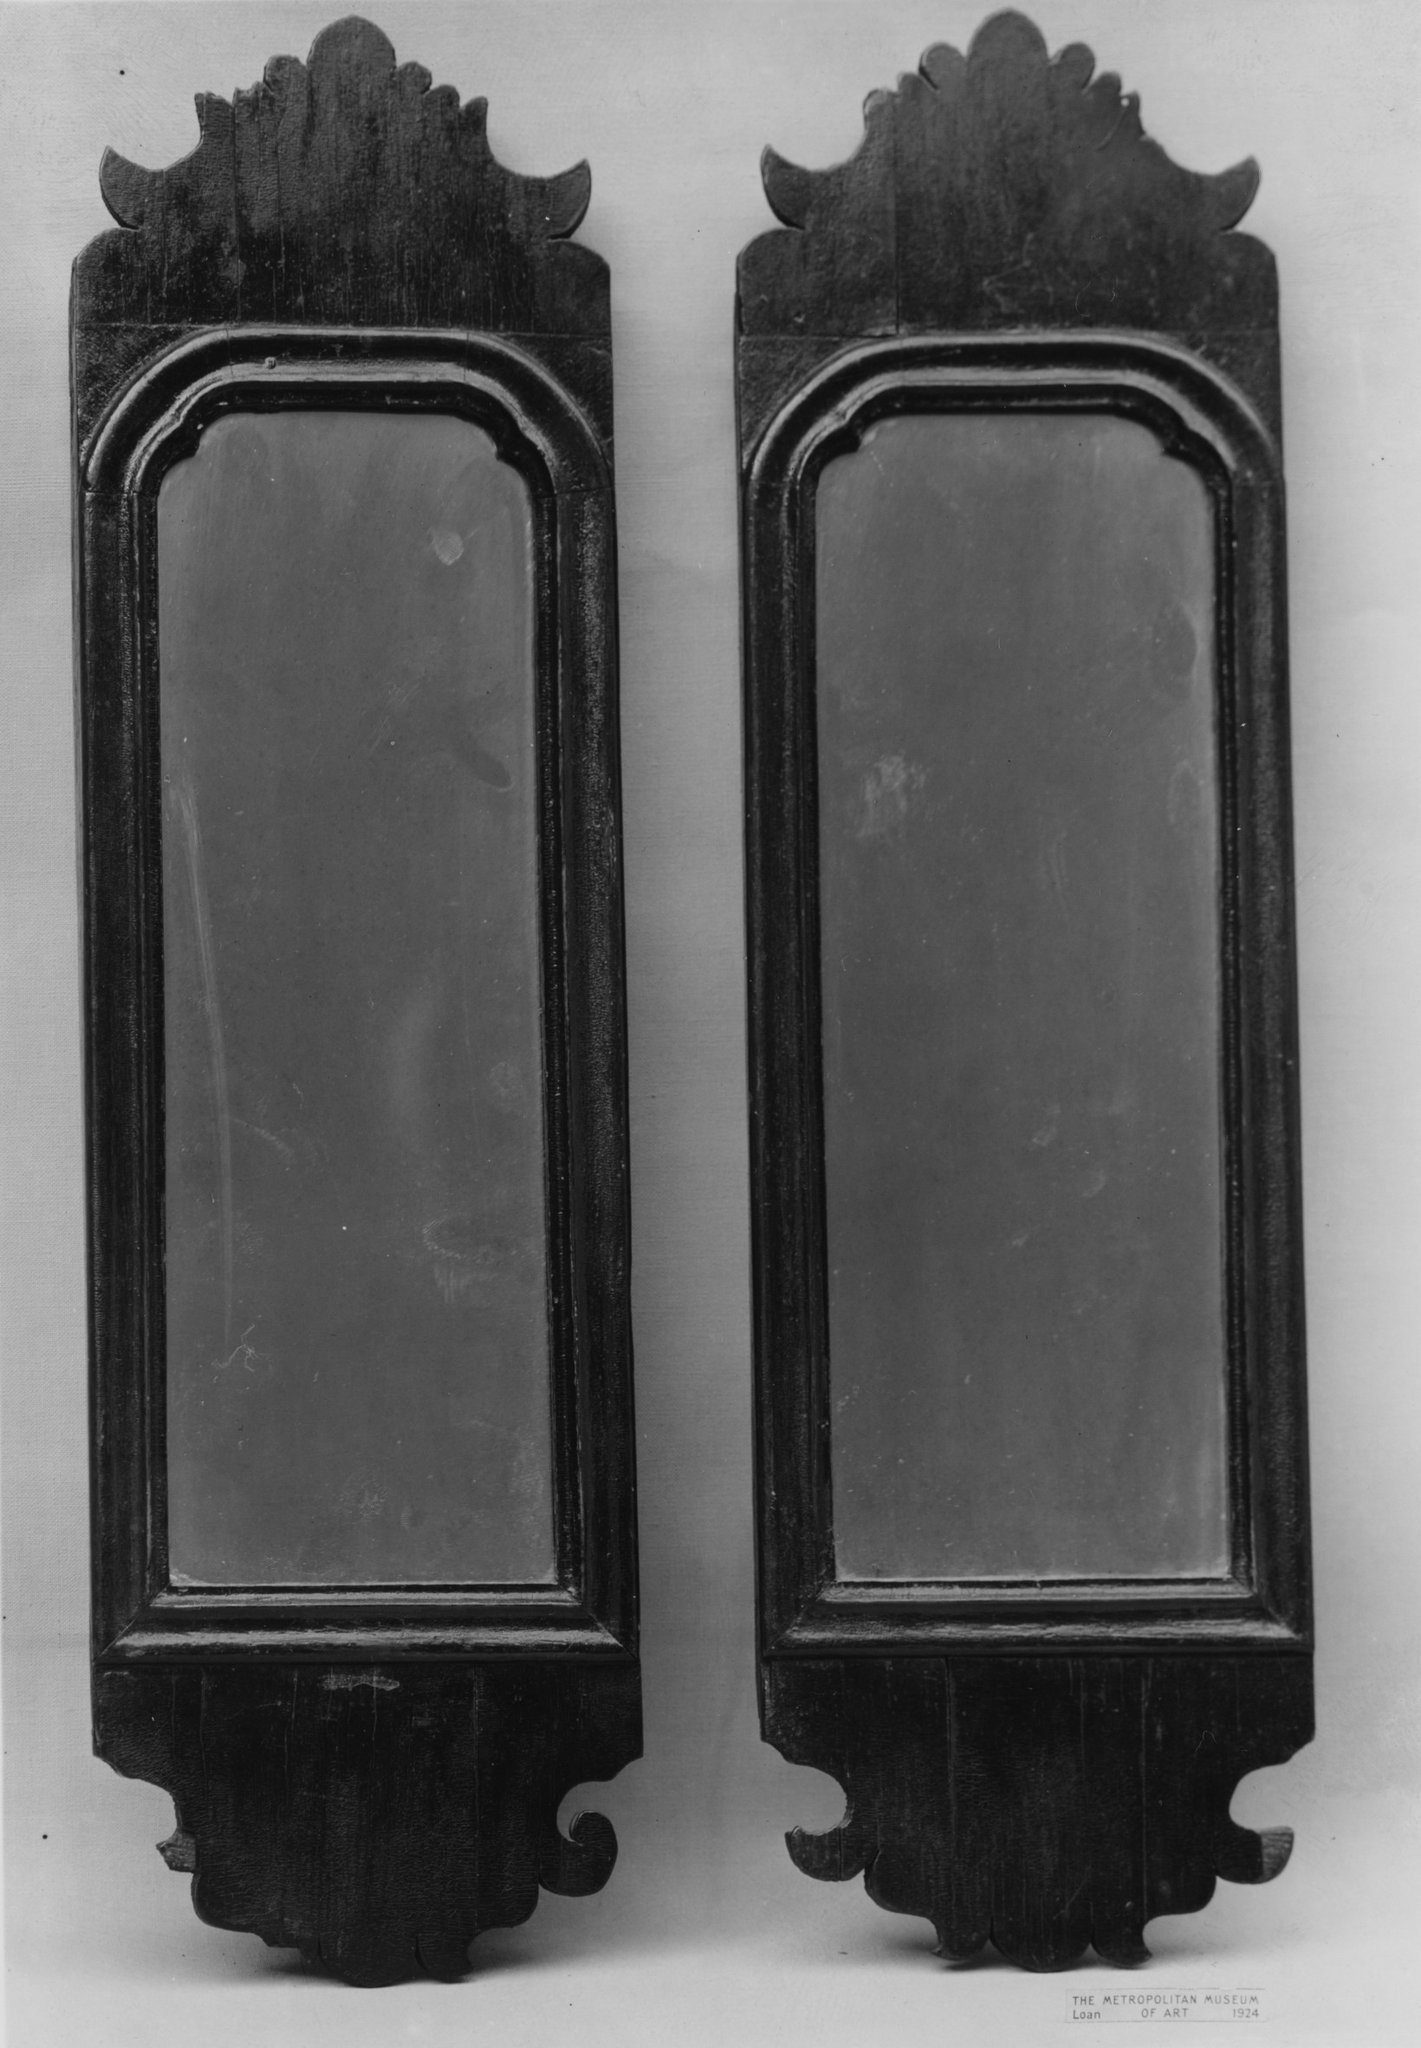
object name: looking glass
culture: american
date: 1740-1790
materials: wood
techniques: veneering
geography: united states